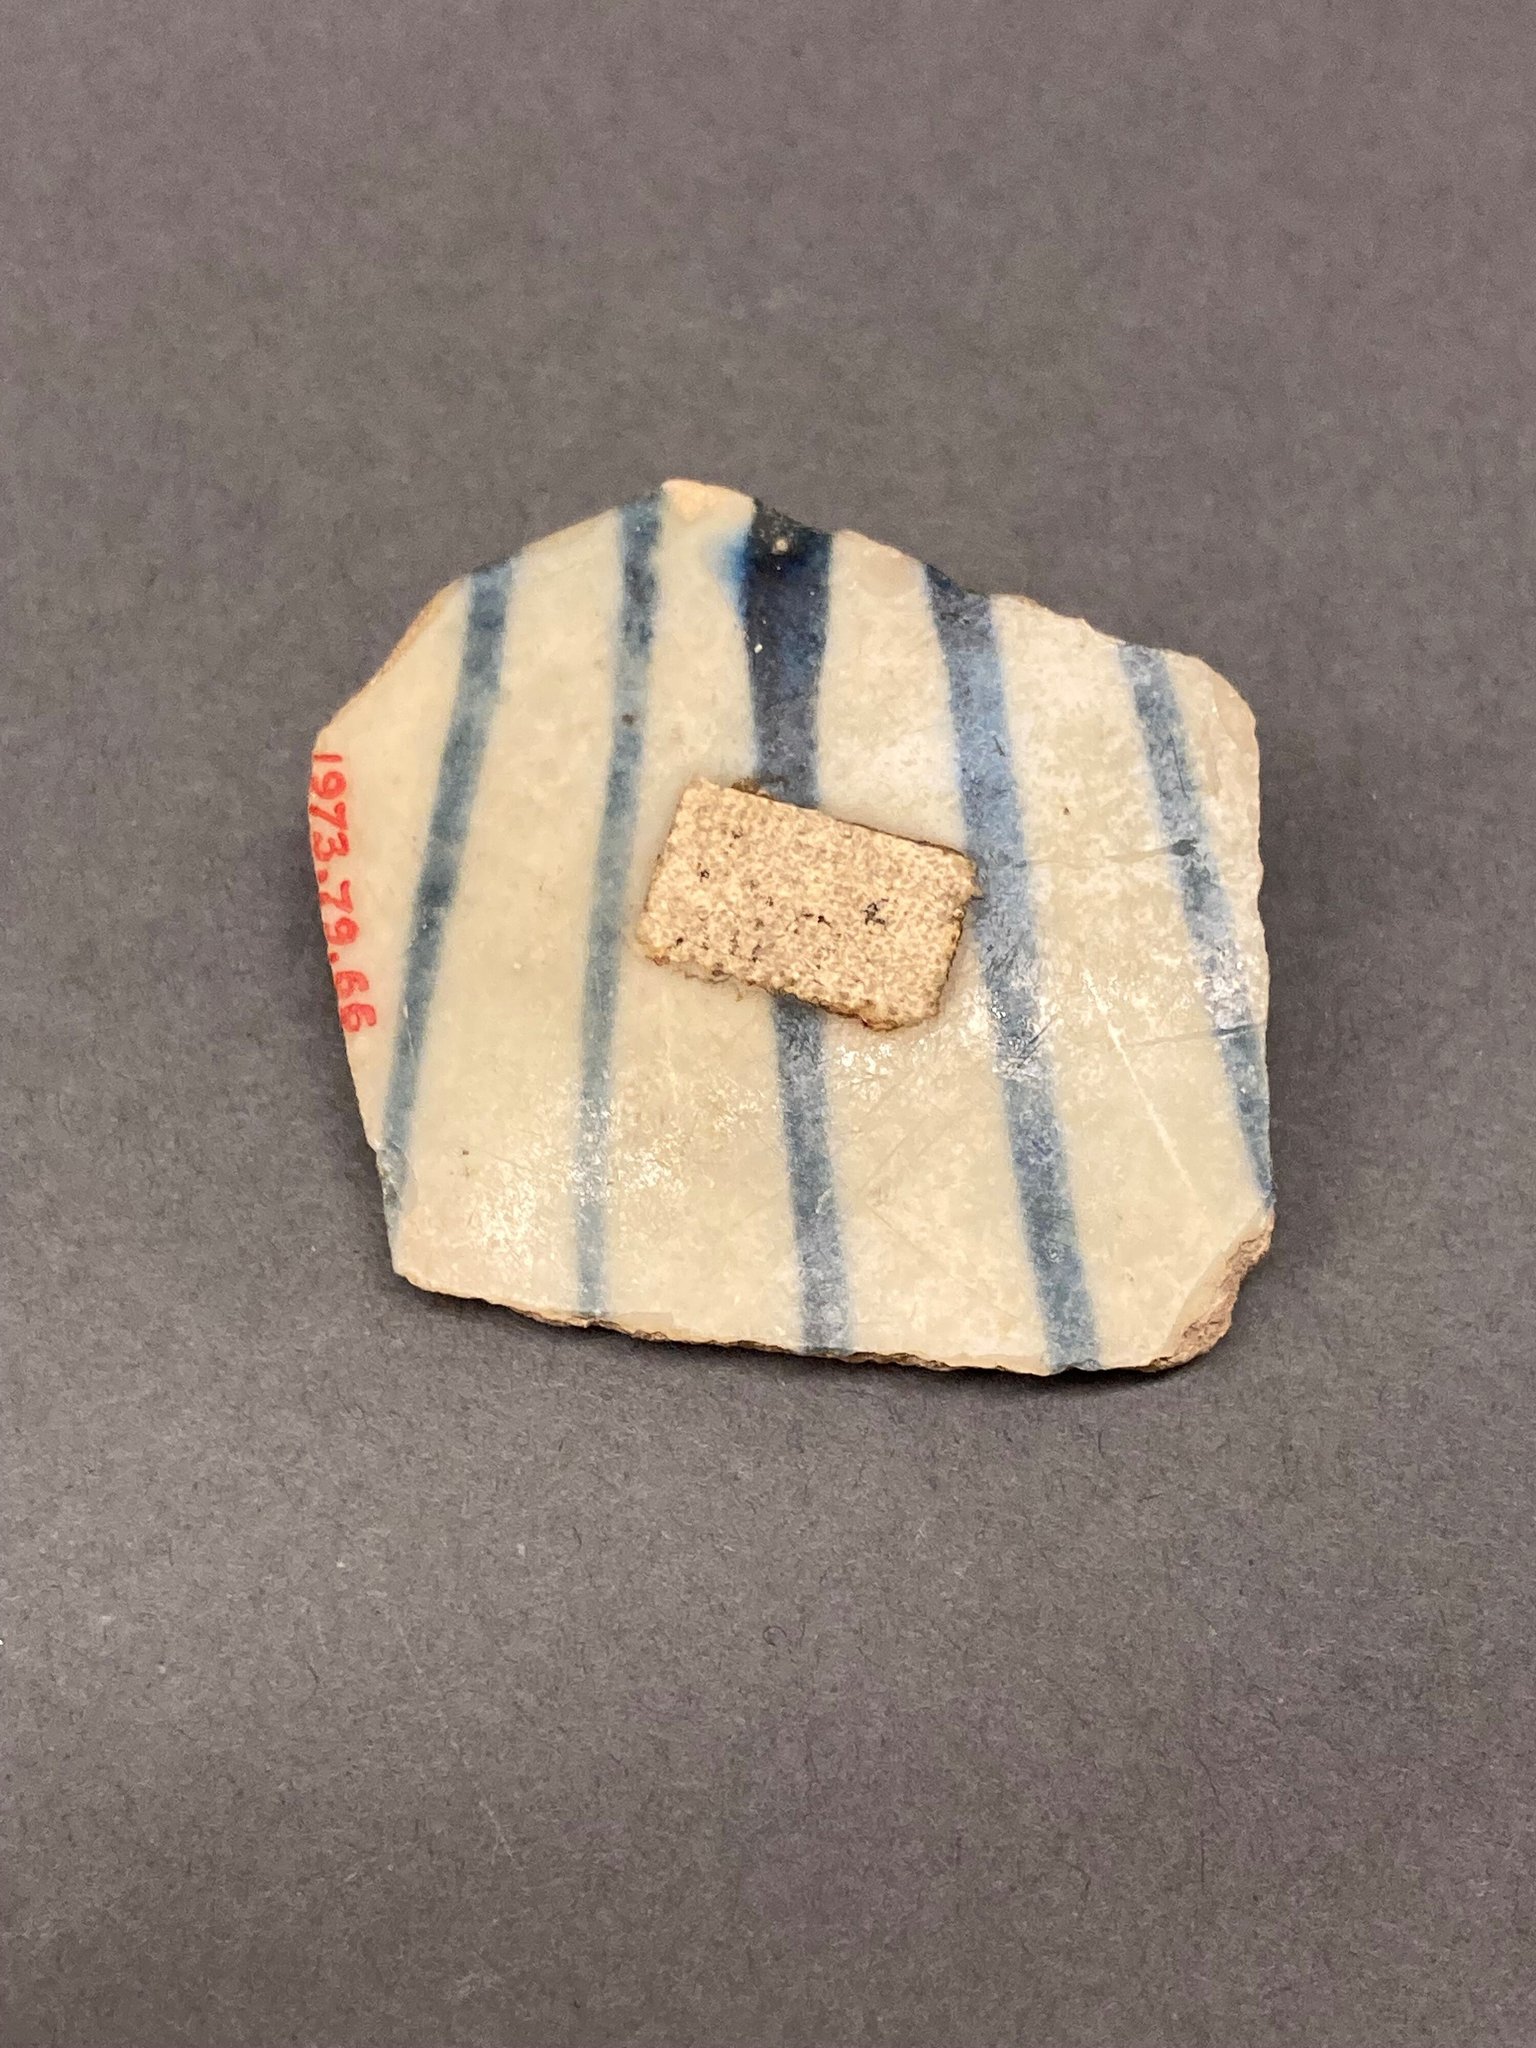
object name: fragment of a bowl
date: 1201-1600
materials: glaze, stonepaste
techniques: painting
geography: egypt